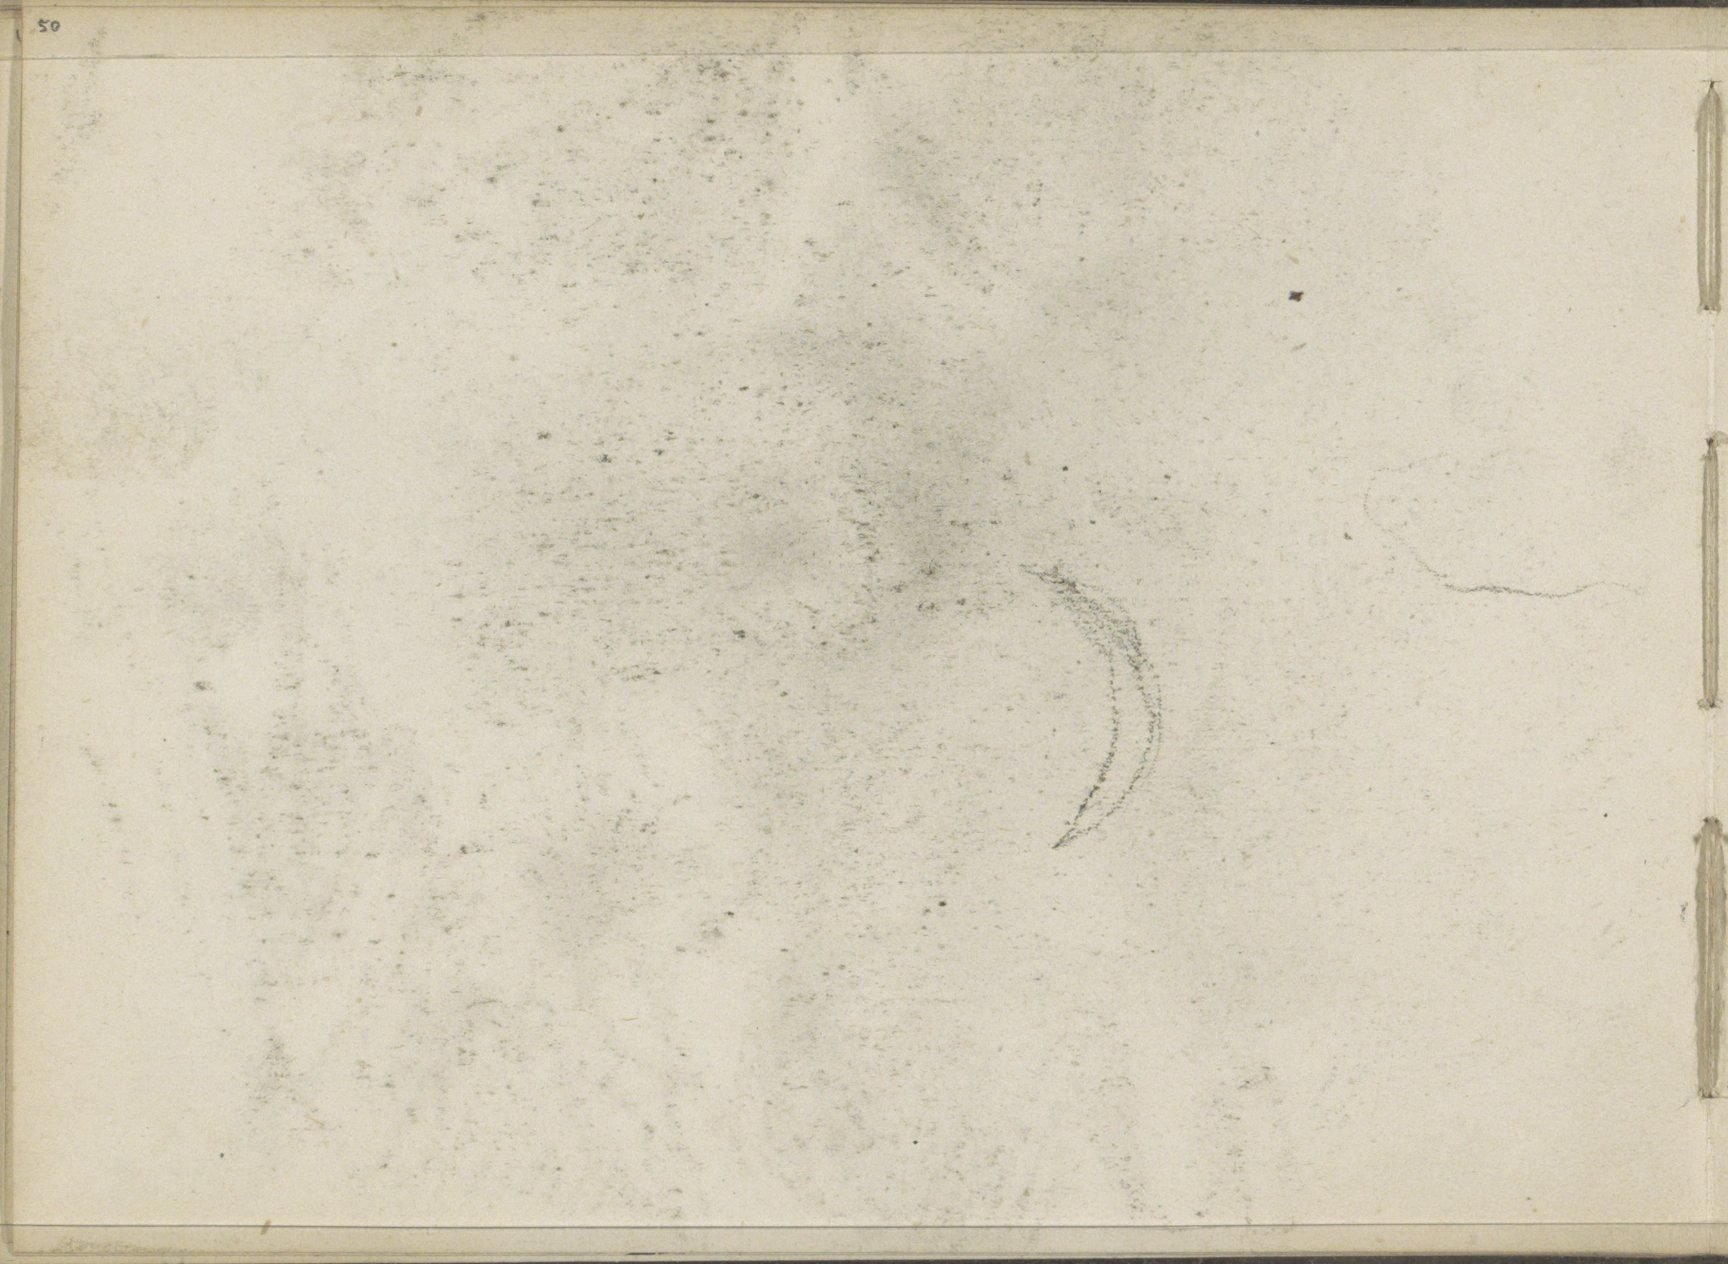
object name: sketchbook leaf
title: Studie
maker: marius bauer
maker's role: draughtsman, print maker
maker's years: 1867-1932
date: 1877-1932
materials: chalk, paper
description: Pagina 50 uit een schetsboek met 32 bladen.